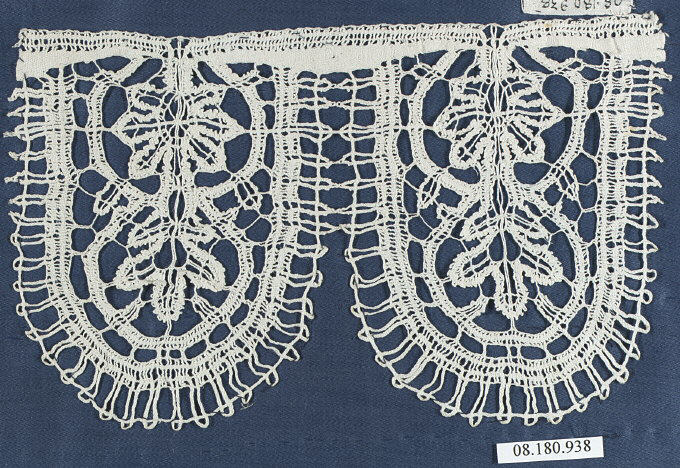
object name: fragment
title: Fragment (two parts)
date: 1601-1700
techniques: lace